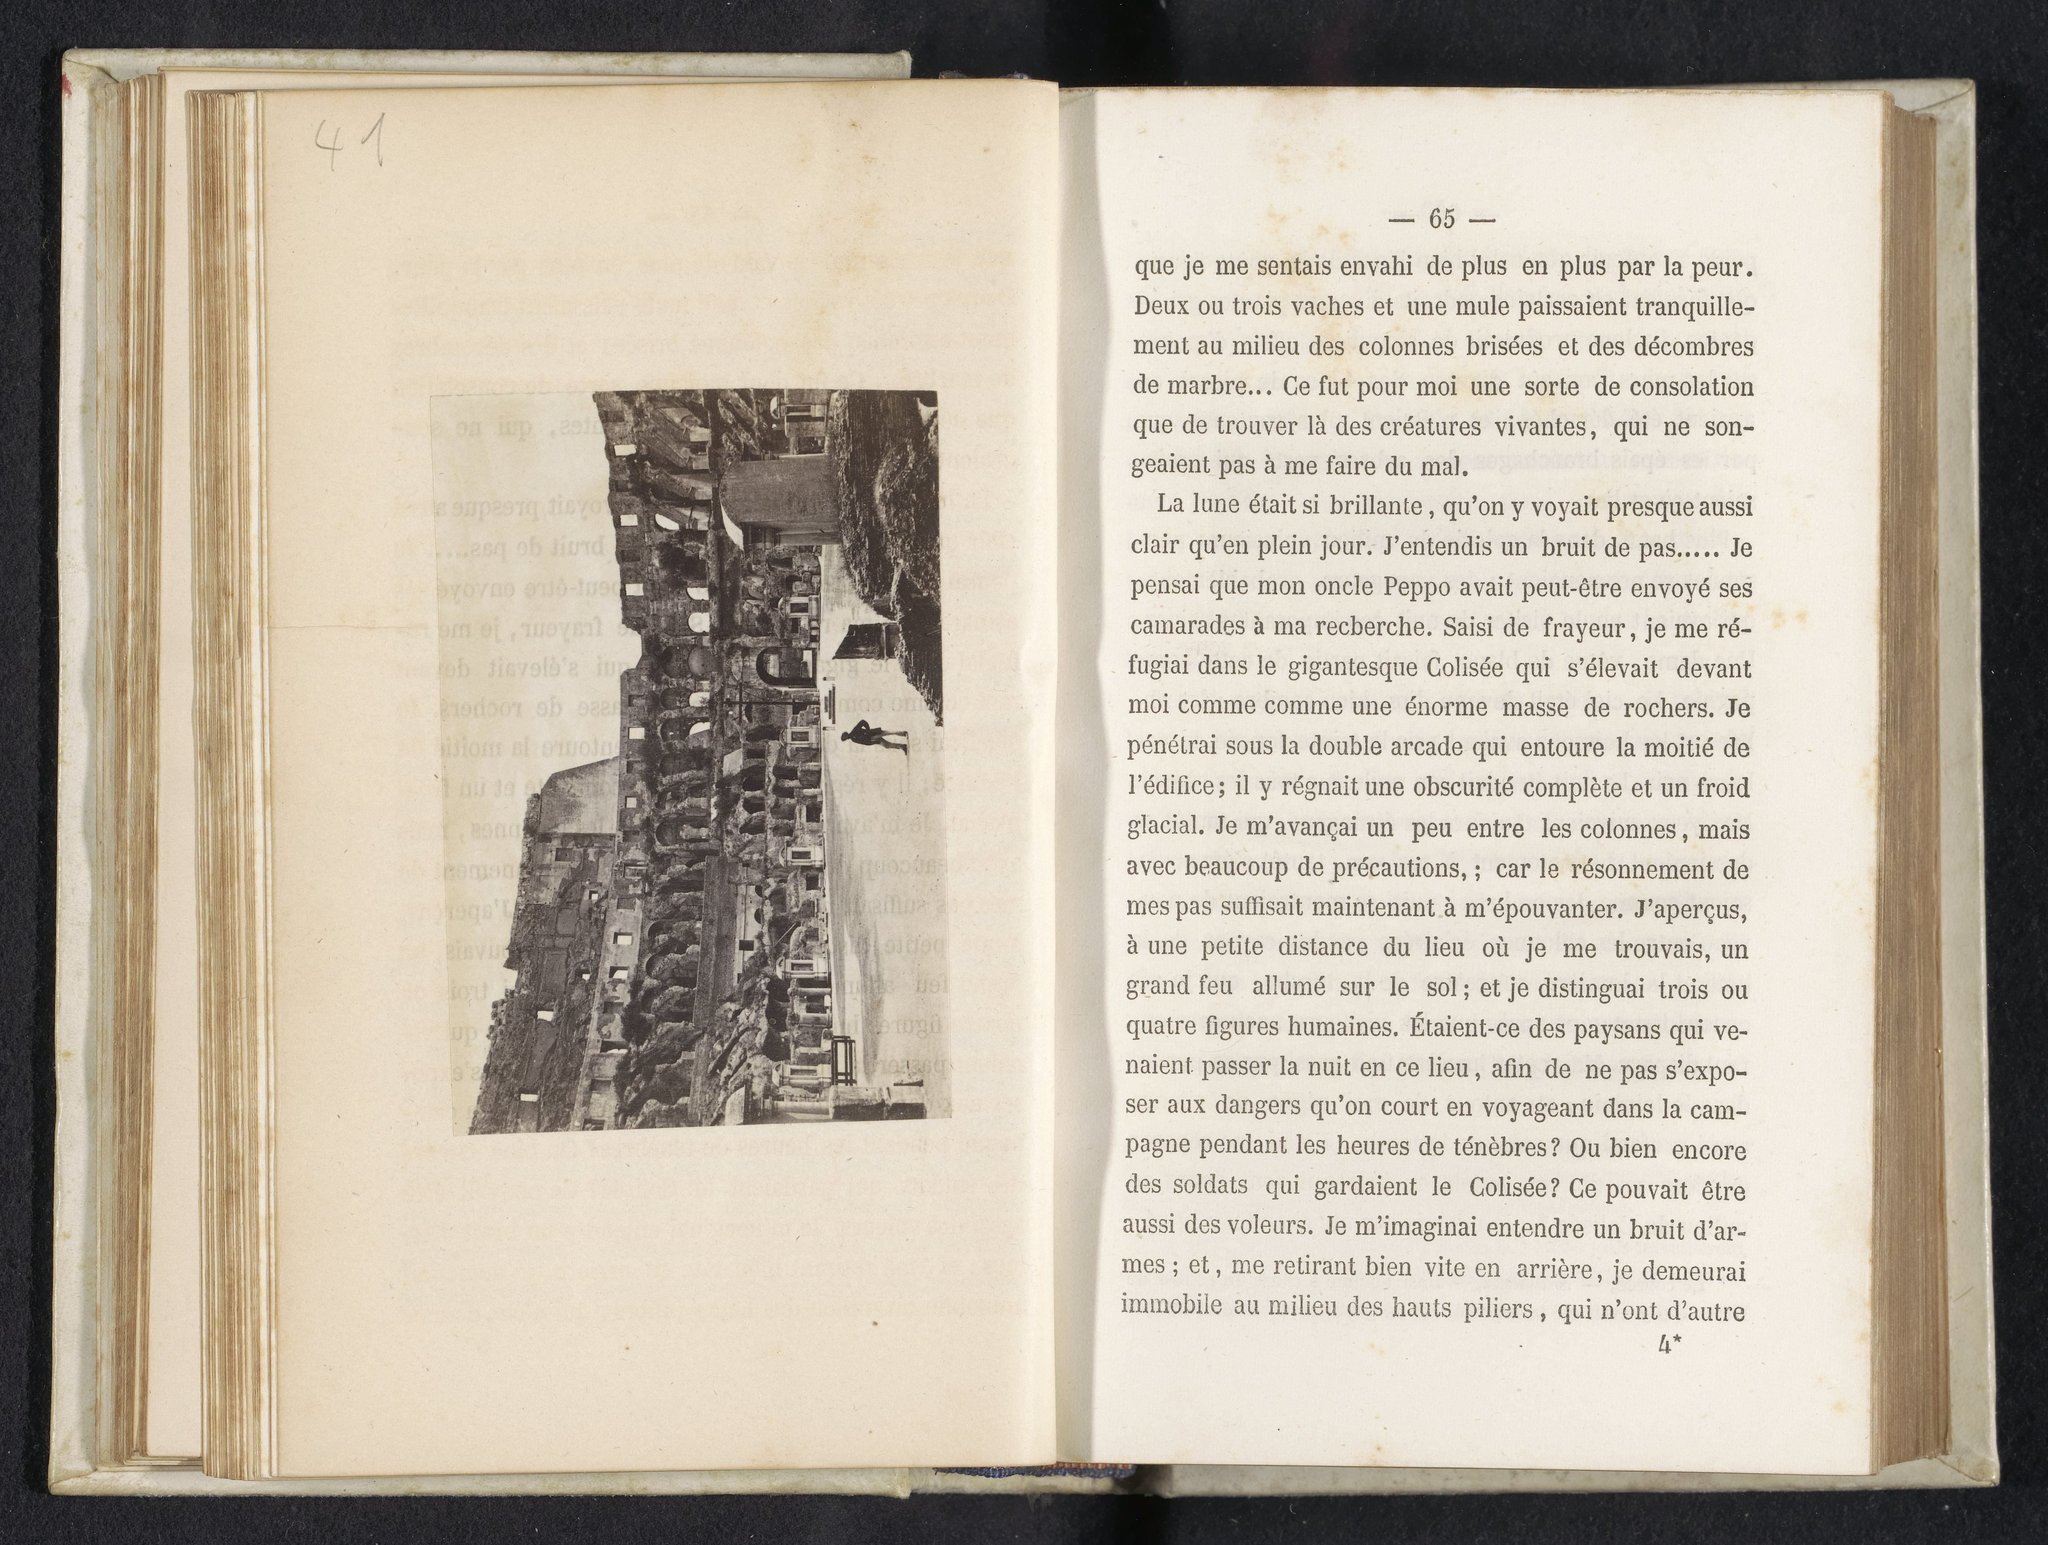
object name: page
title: Interieur van het Colosseum te Rome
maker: Anonymous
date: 1850-1860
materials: photographic support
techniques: albumen print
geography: rome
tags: ruin of a building ~ architecture, theatre (building) - aa - open-air performances